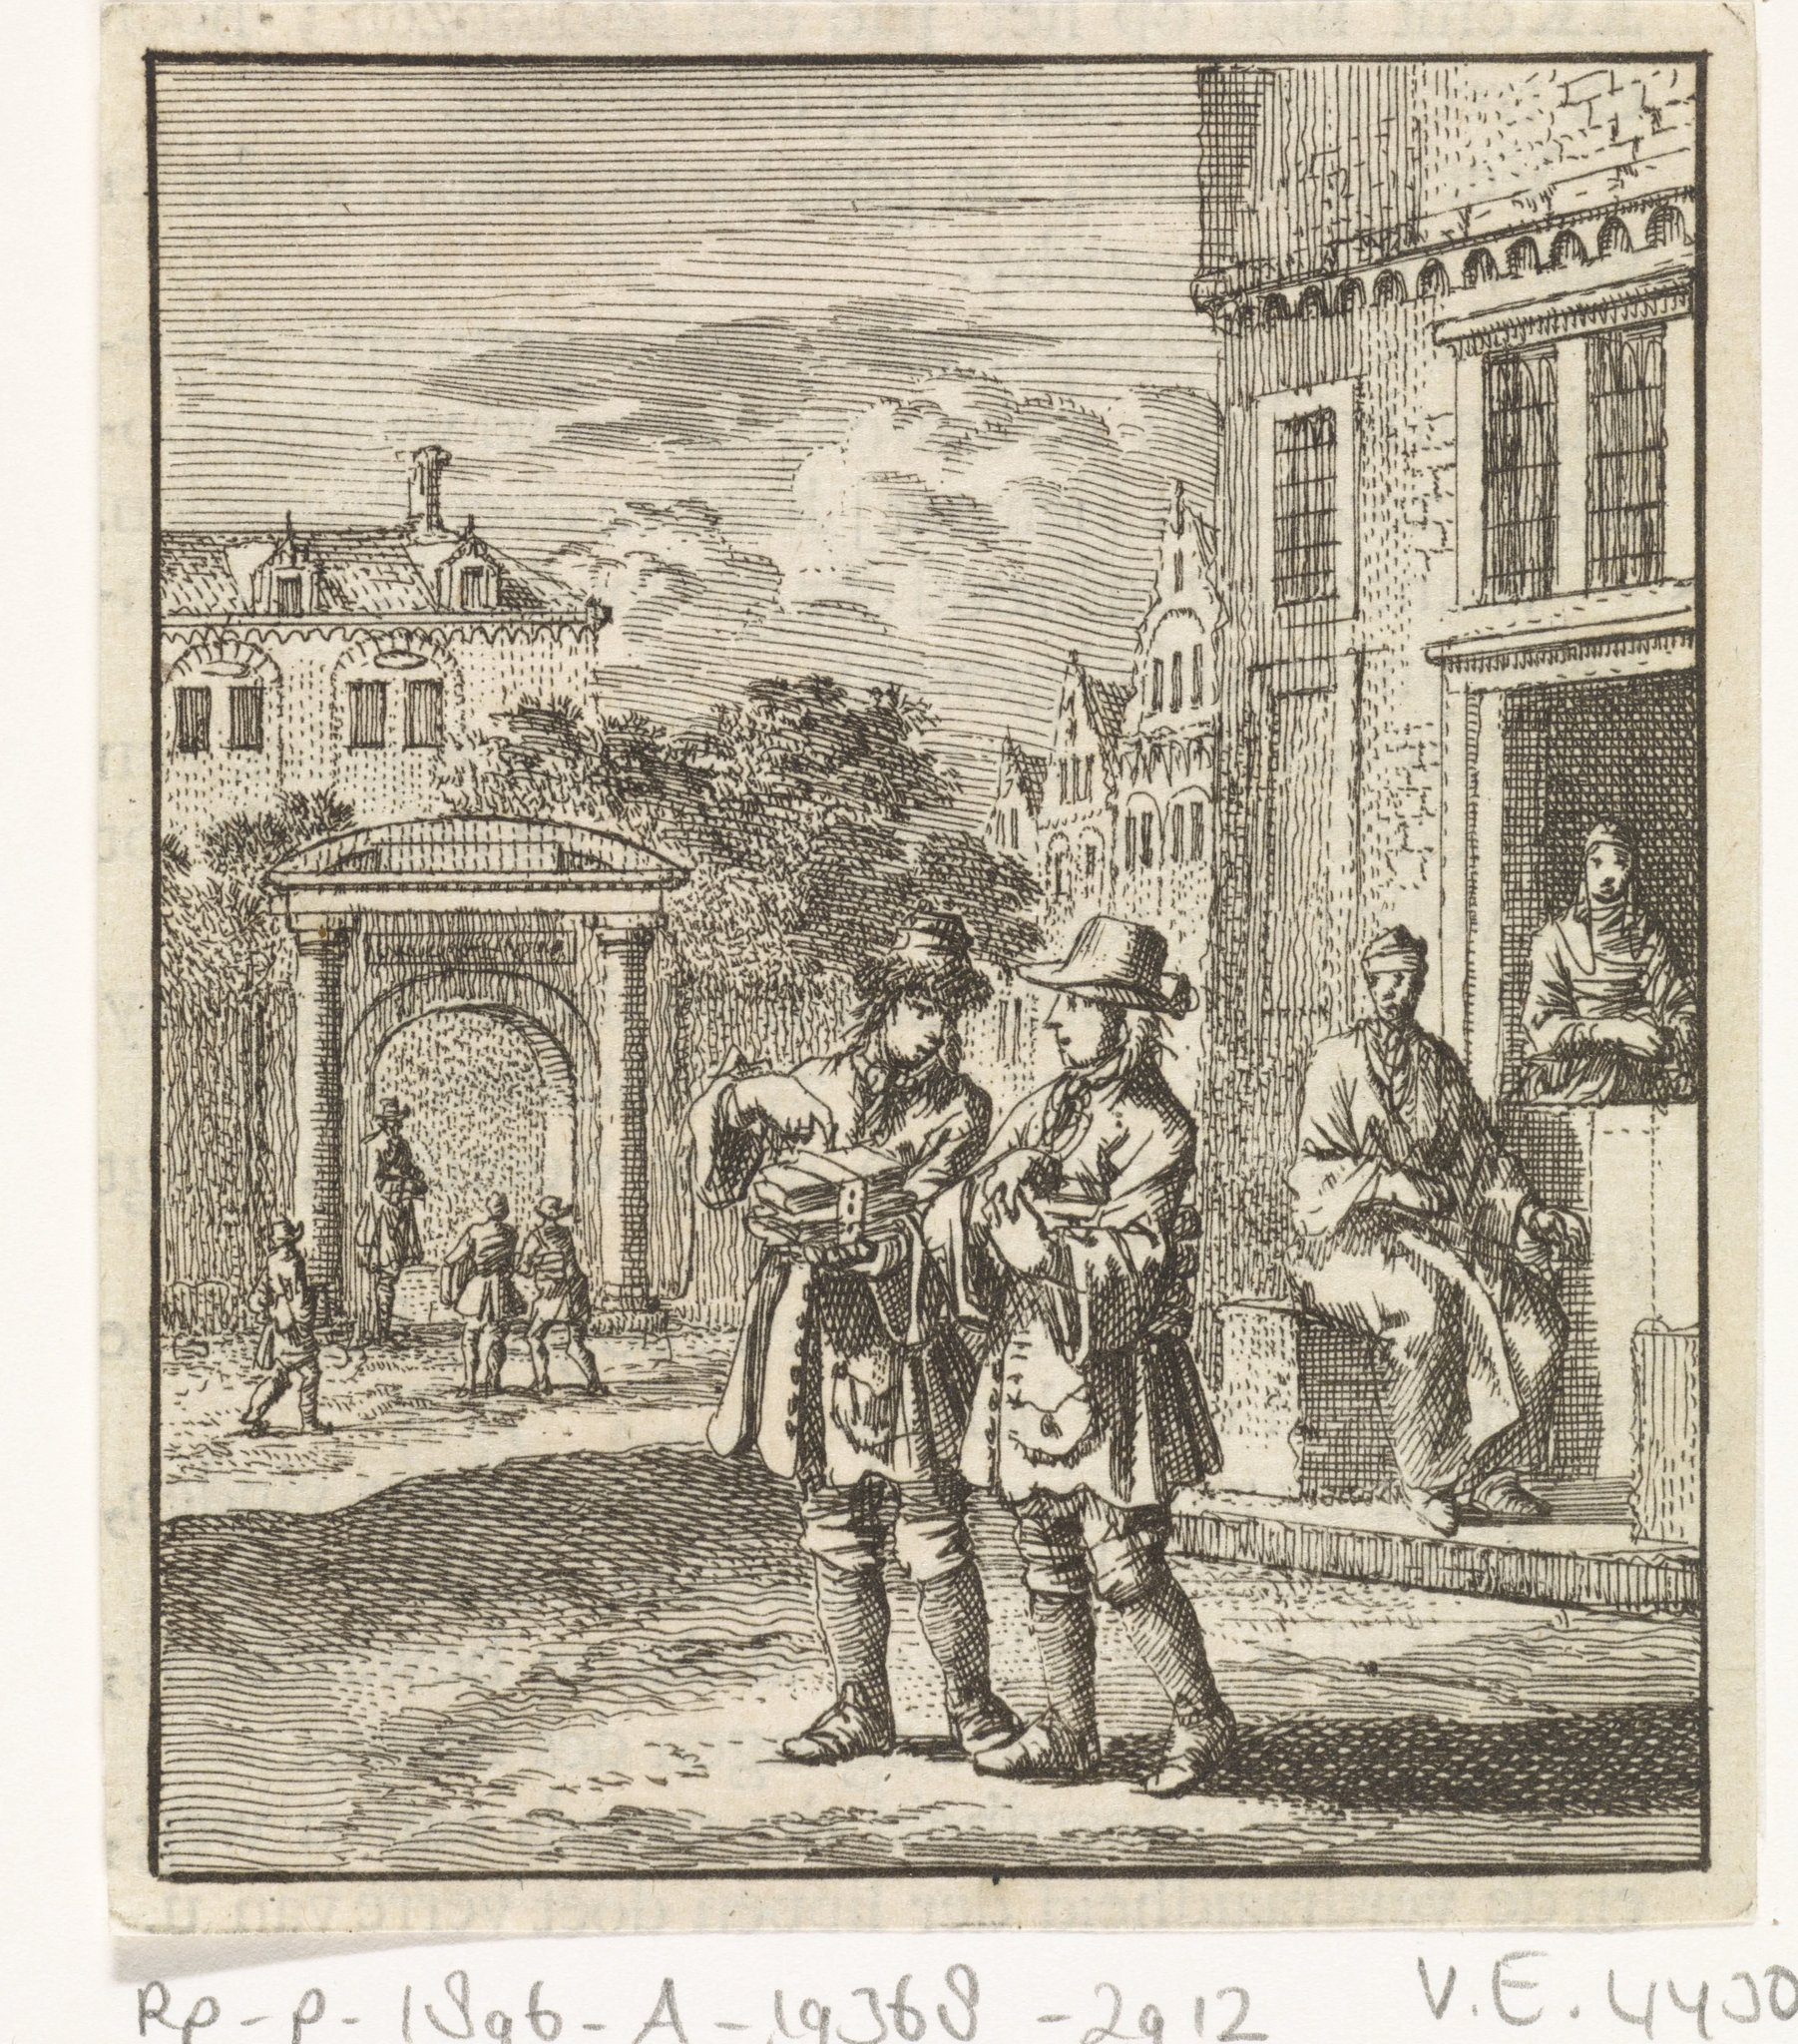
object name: print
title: Twee studenten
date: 1712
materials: paper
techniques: etching, letterpress printing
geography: amsterdam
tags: child (young man, young woman) leaving his (her) parents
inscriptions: collector's mark: Lugt 2228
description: Illustratie uit: Luyken, Jan. Des menschen begin, midden en einde. Amsterdam: Wed. Pieter Arentsz II en Cornelis van der Sys, 1712, p. 93.